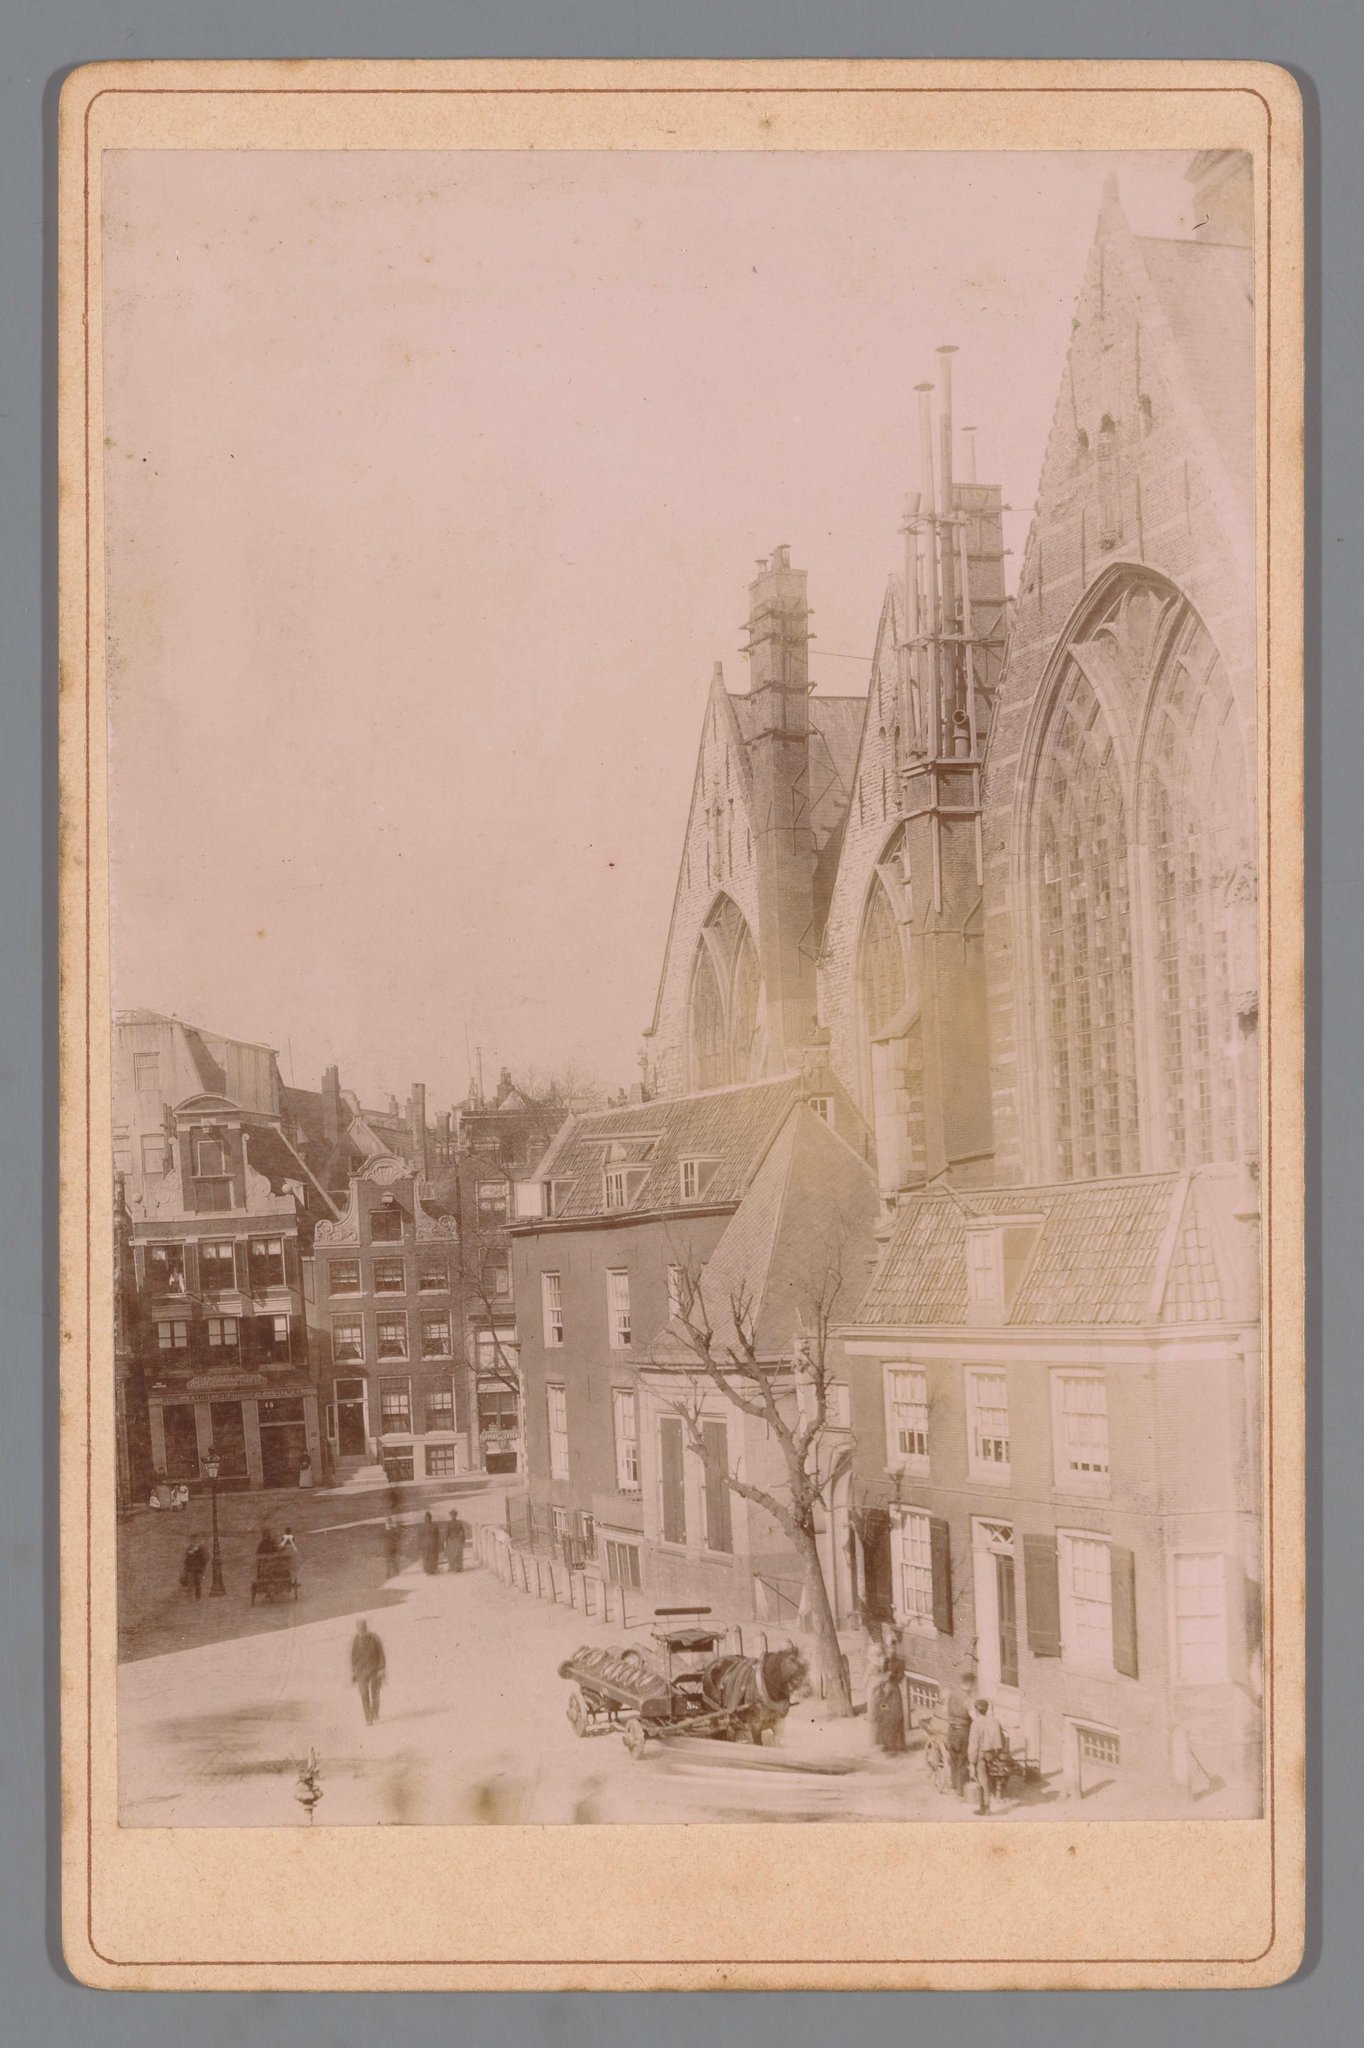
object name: cabinet photograph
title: Gezicht op het Oudekerksplein met de Oude Kerk in Amsterdam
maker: Anonymous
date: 1890-1930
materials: cardboard, photographic support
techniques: gelatin silver print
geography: amsterdam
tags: church (exterior), street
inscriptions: name: ‘[.]n Pijpe[.]’